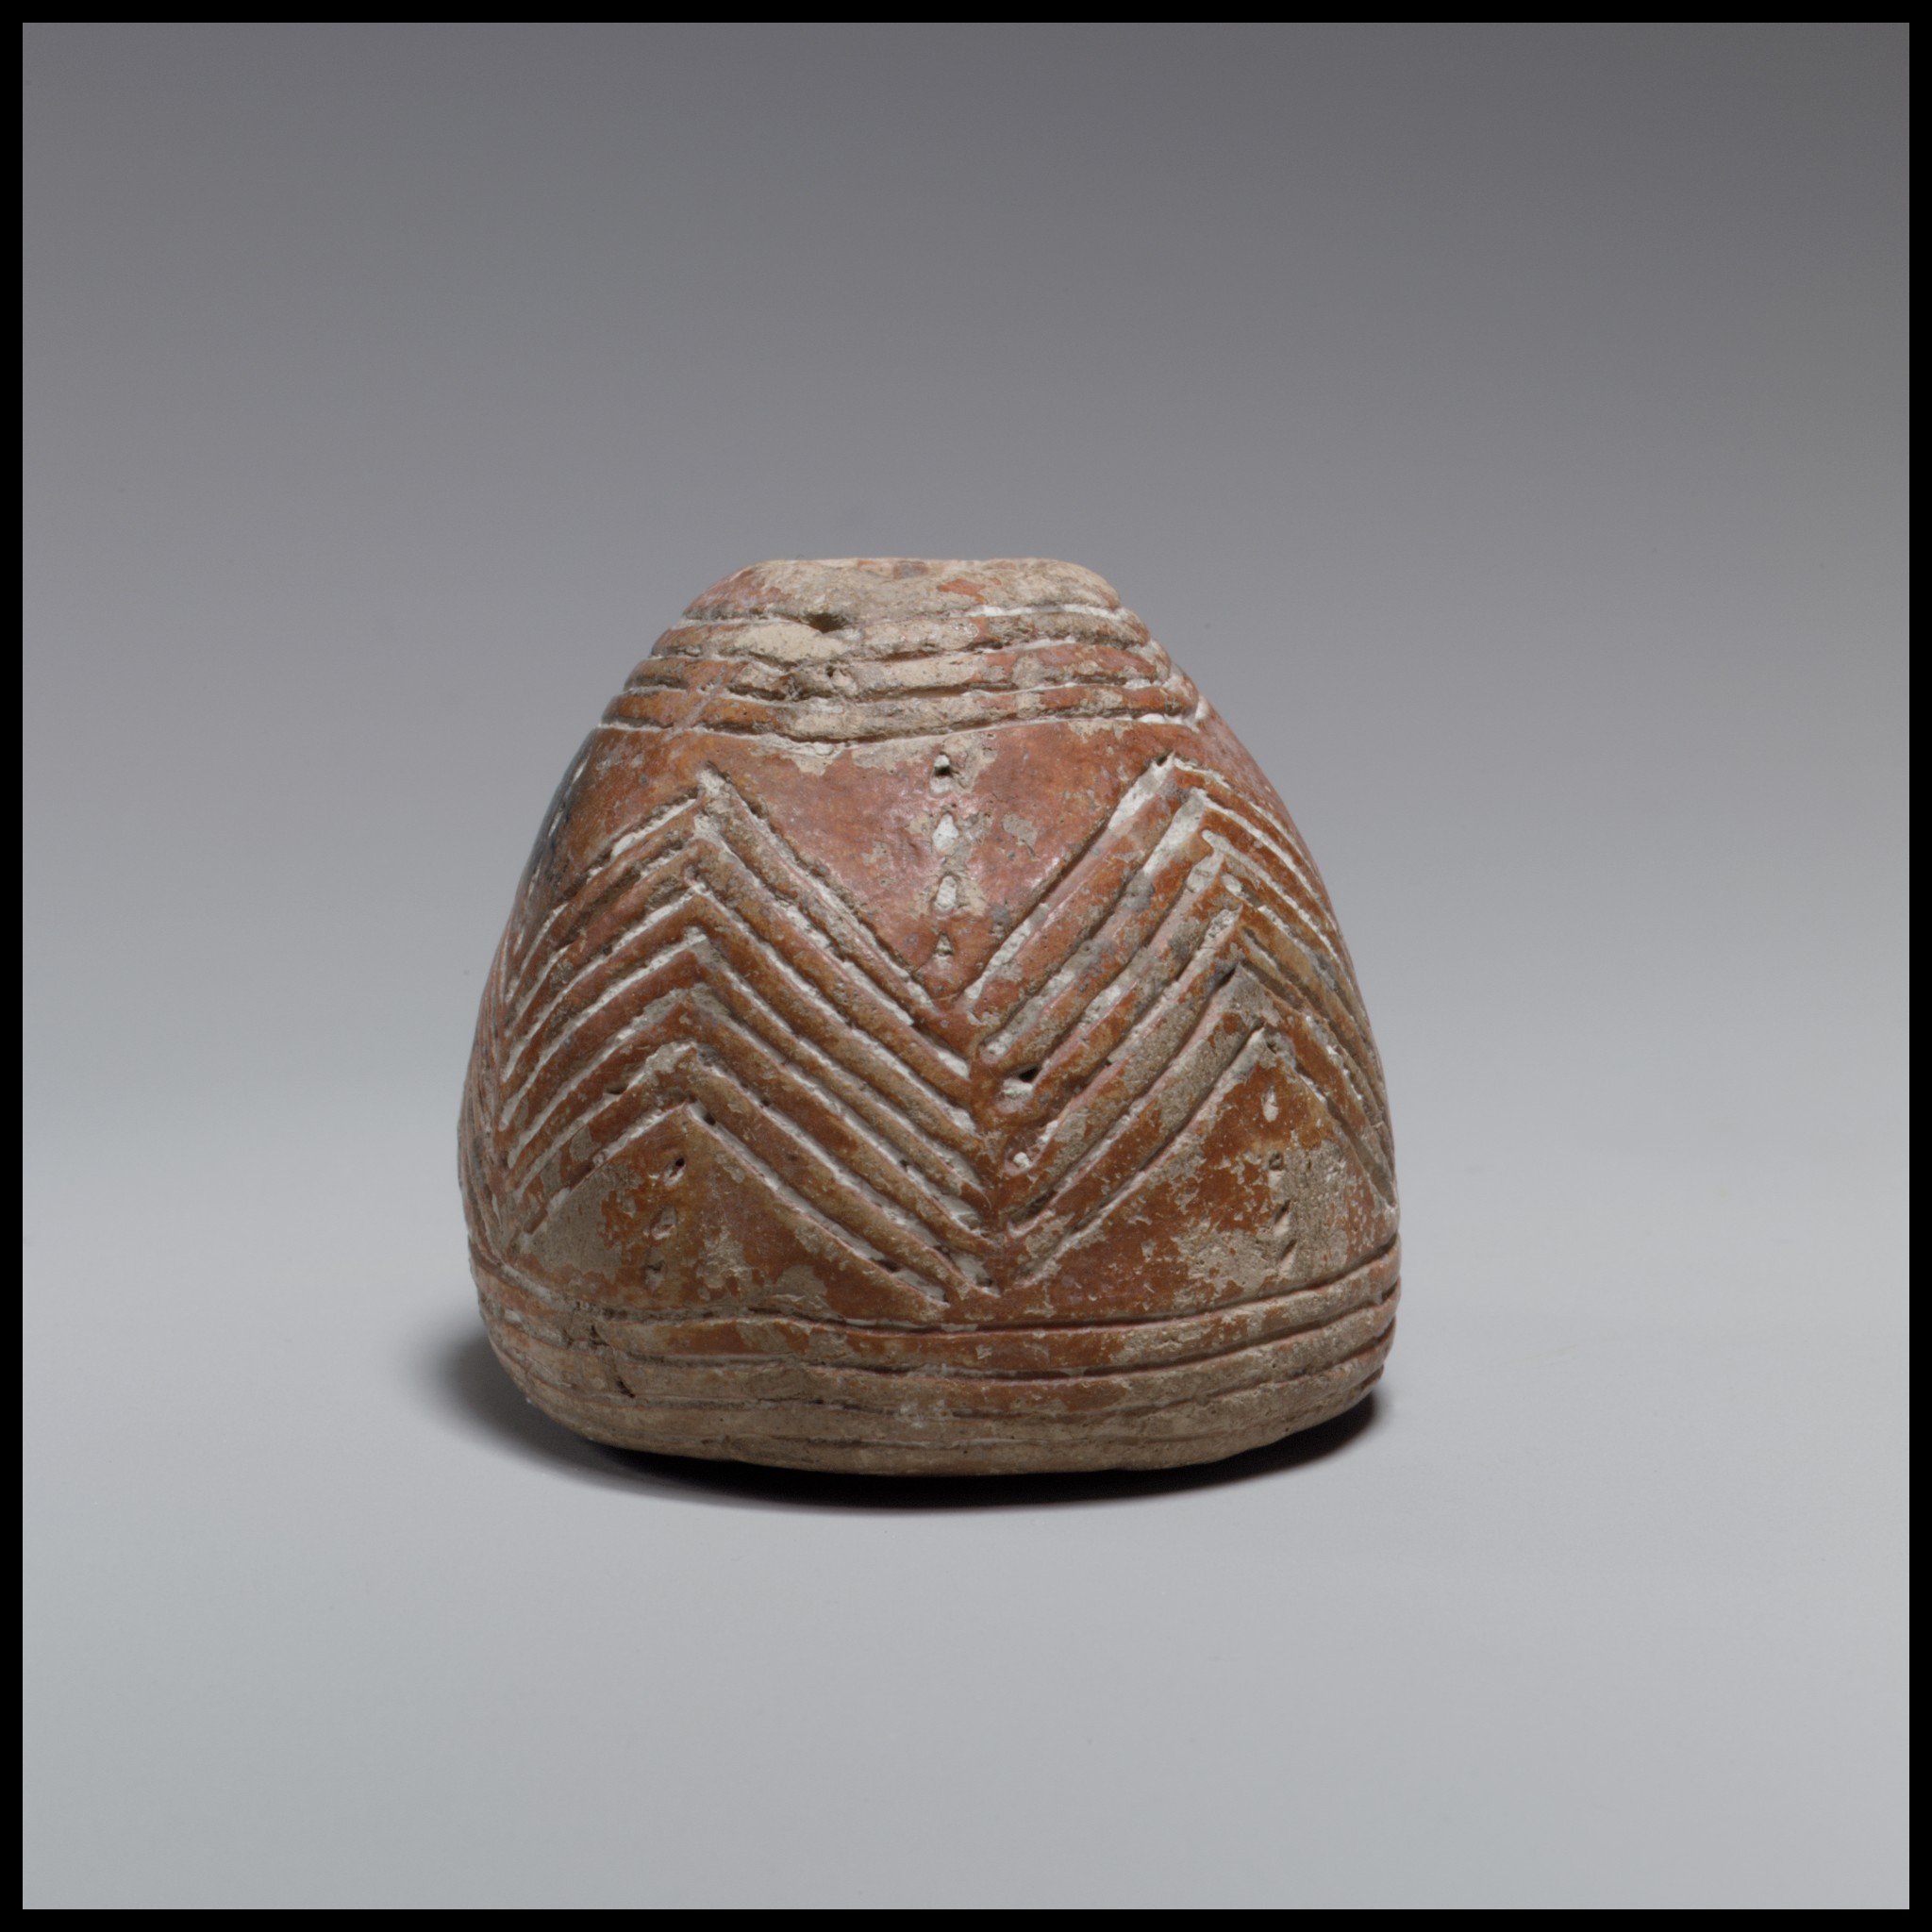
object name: spindle whorl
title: Terracotta conical-hemispherical spindle-whorl with flat base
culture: cypriot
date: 2000-1725 BCE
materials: terracotta